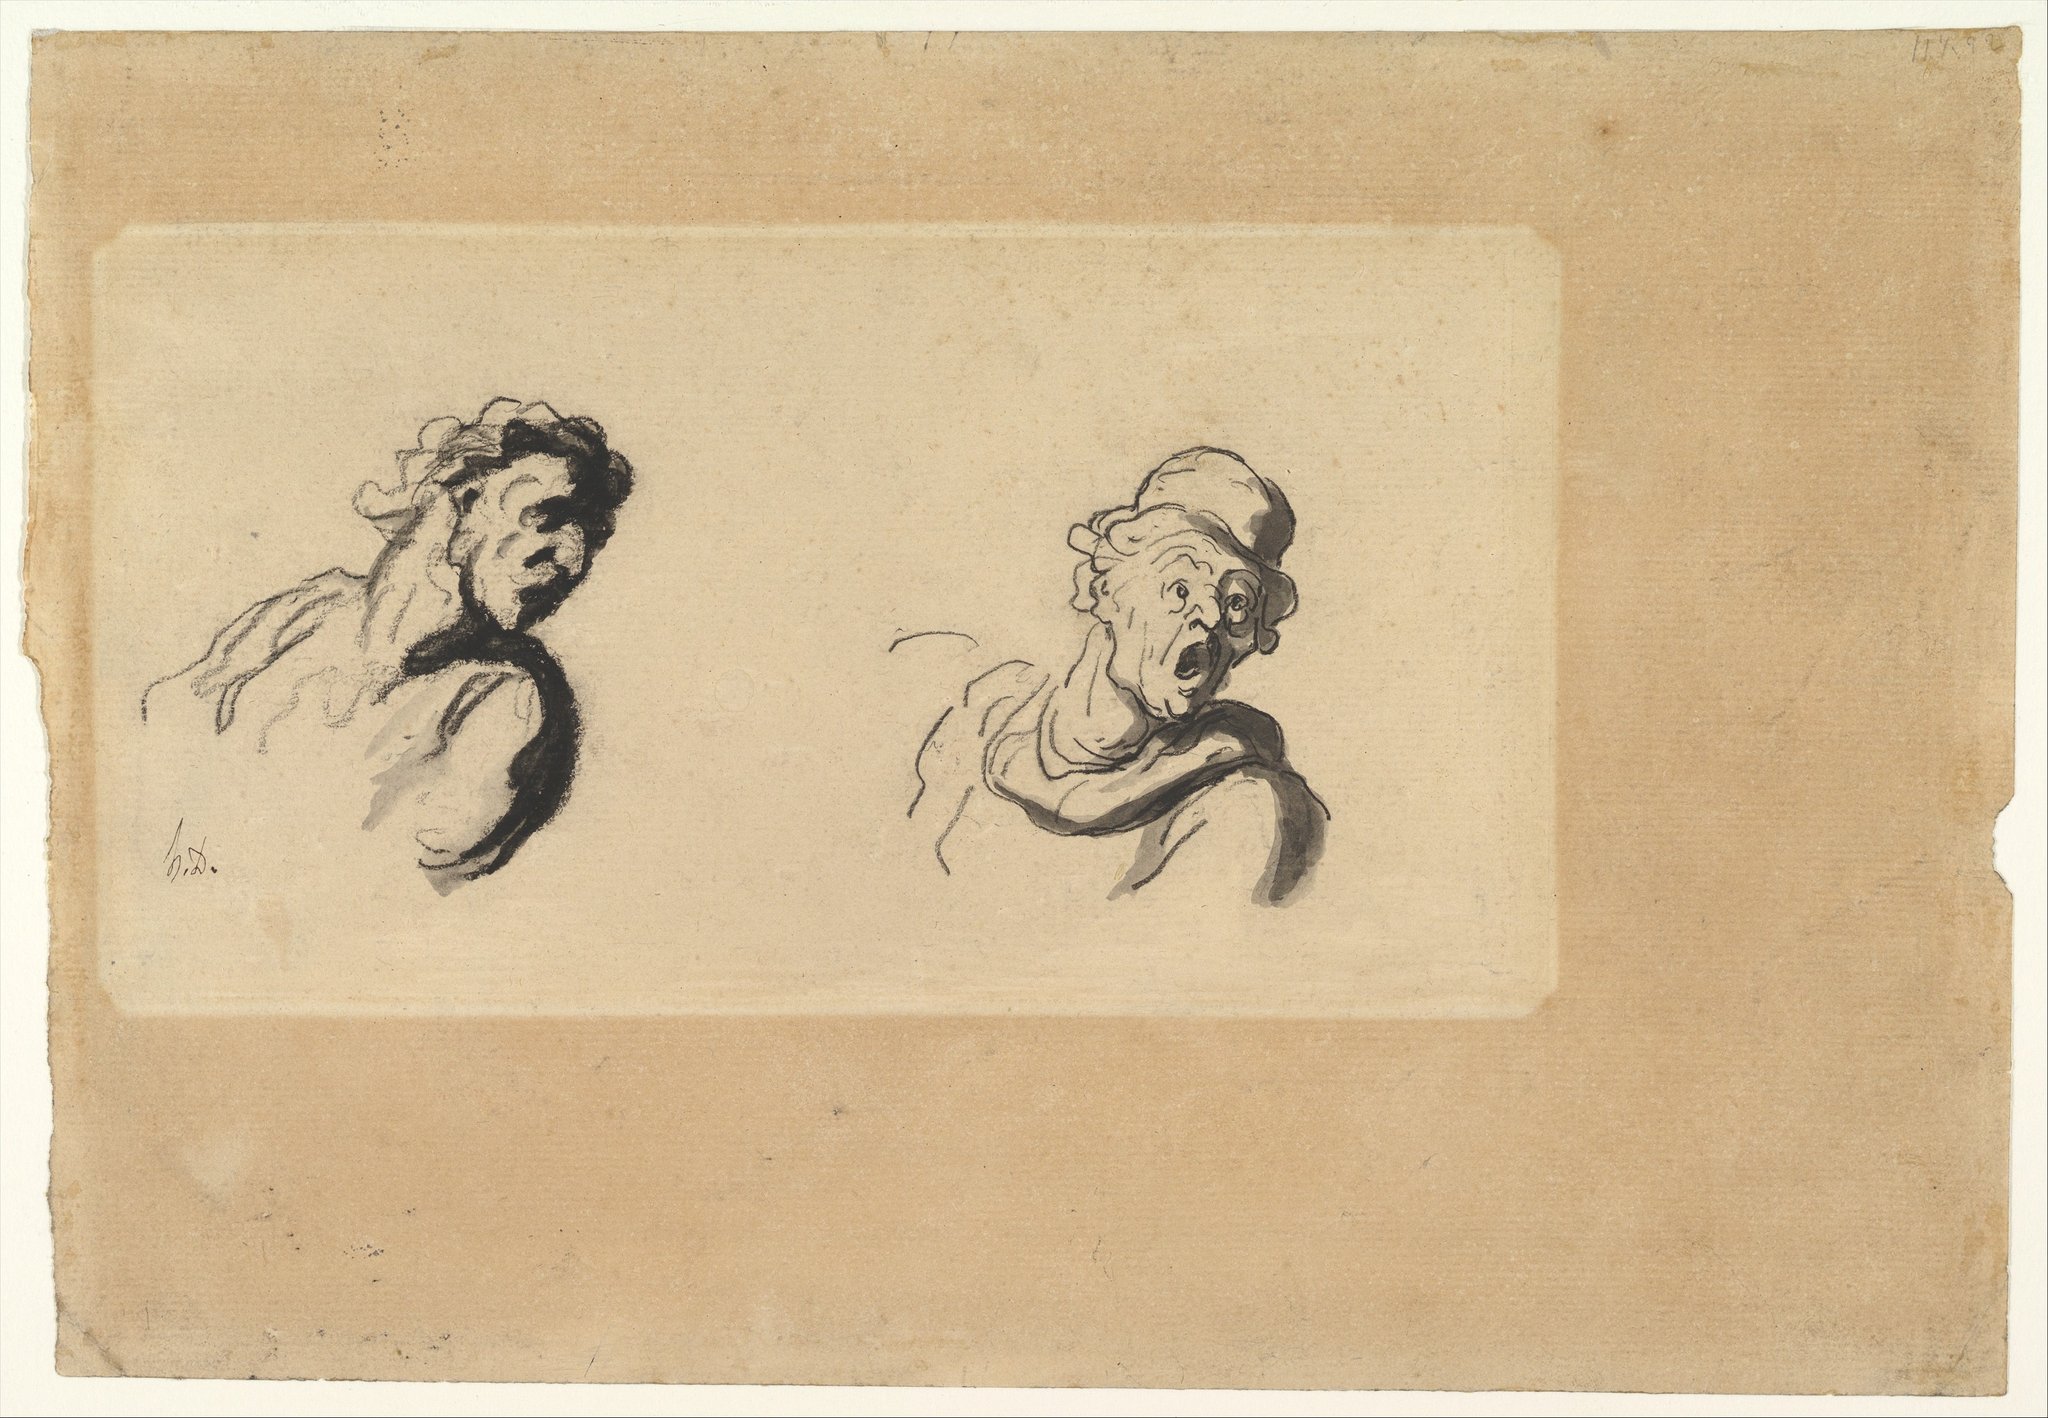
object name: drawing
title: Two Male Heads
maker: honoré daumier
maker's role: artist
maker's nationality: french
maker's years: 1808-1879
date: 1801-1900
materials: crayon, paper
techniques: wash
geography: france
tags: heads,men